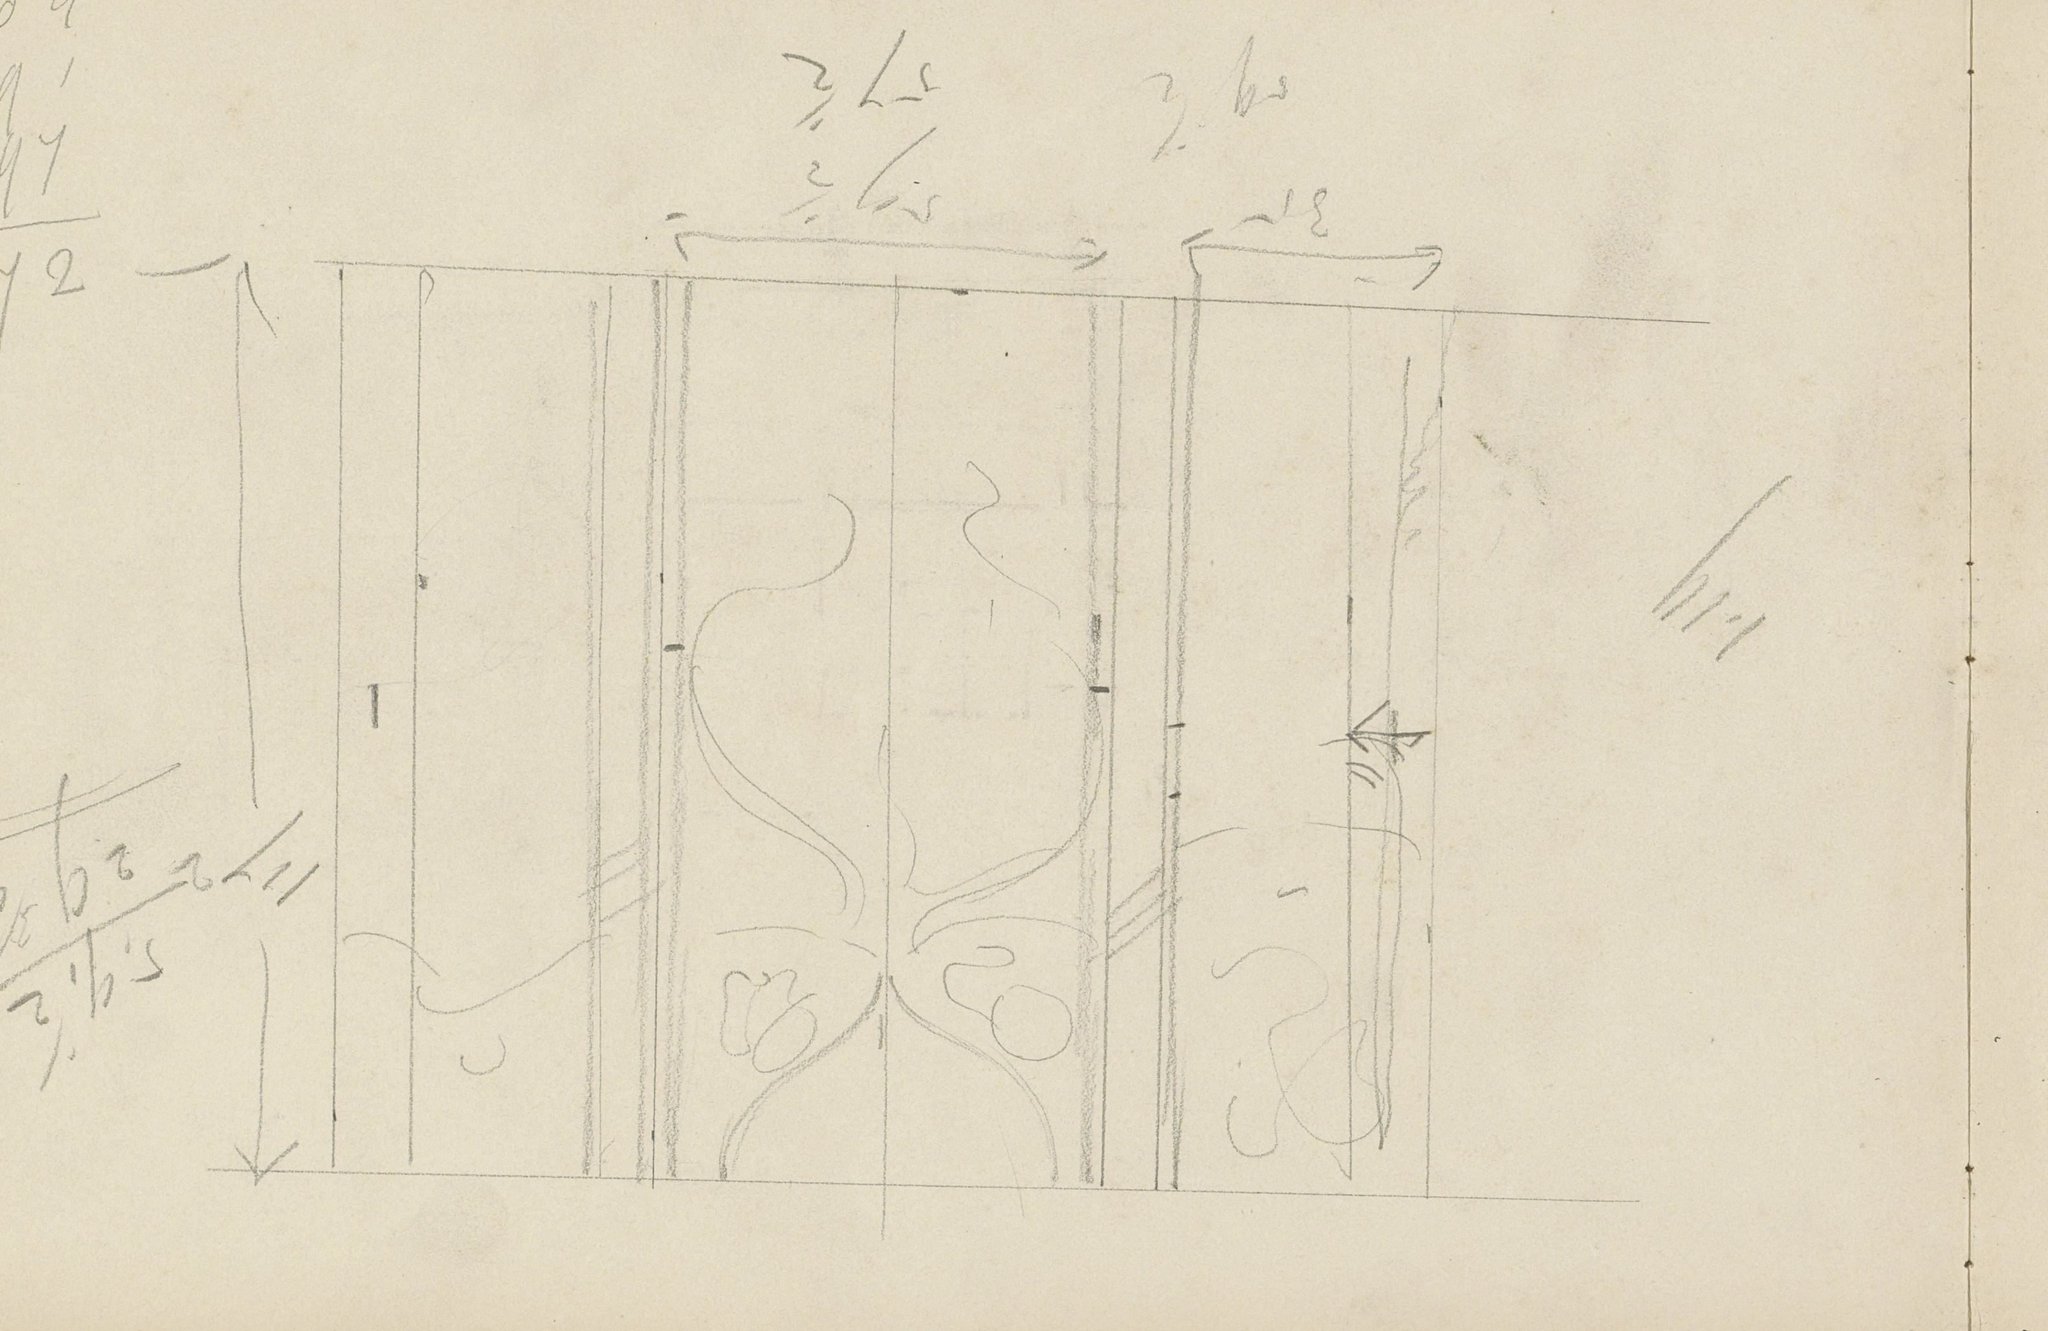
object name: sketchbook leaf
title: Ontwerp, mogelijk voor een meubel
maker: carel adolph lion cachet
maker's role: draughtsman, print maker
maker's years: 1864-1945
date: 1908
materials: paper, pencil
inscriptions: annotation: ‘[...]’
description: Blad 4 verso uit een schetsboek met 25 bladen.